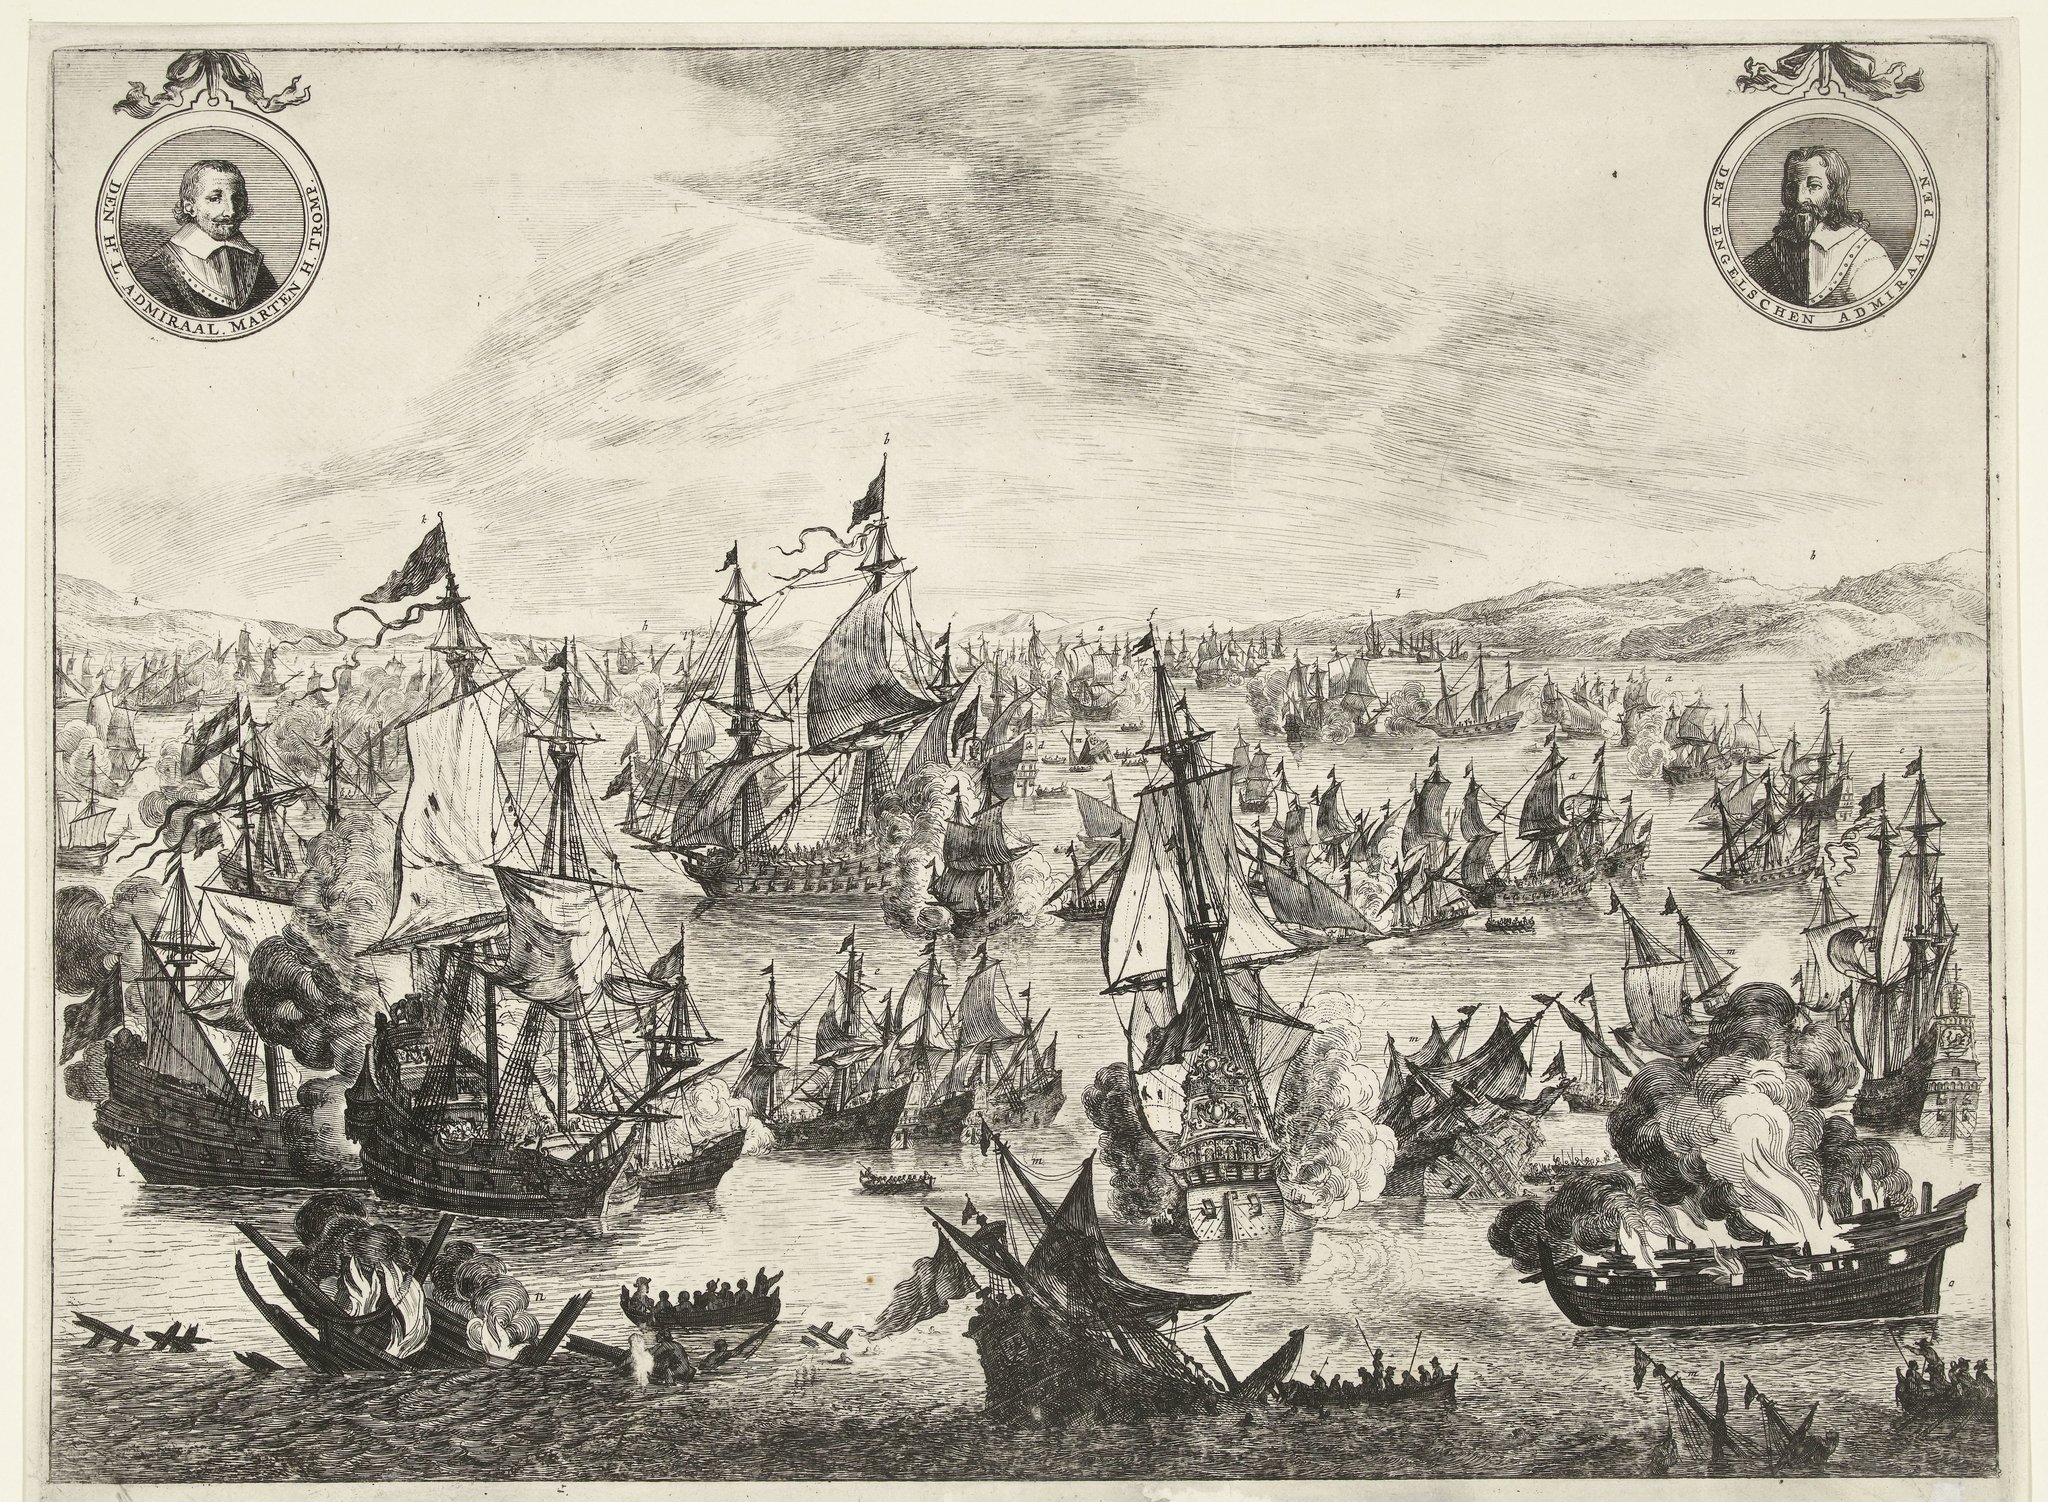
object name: print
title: Zeeslag bij Terheide, 1653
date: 1649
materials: paper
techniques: etching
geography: northern netherlands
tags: maarten harpertszoon tromp, battle (+ naval force), battle of scheveningen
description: De zeeslag bij Terheide (Zeeslag bij Katwijk) tijdens de Eerste Engelse Oorlog tussen de Staatse vloot onder Maarten Tromp en de Engelse vloot onder George Monck, 10 augustus 1653. Bovenaan de portretten van de admiralen Maarten Tromp en William Penn. Bij de behoort een tekstblad met een beschrijving van de gebeurtenissen en de legenda a-o.